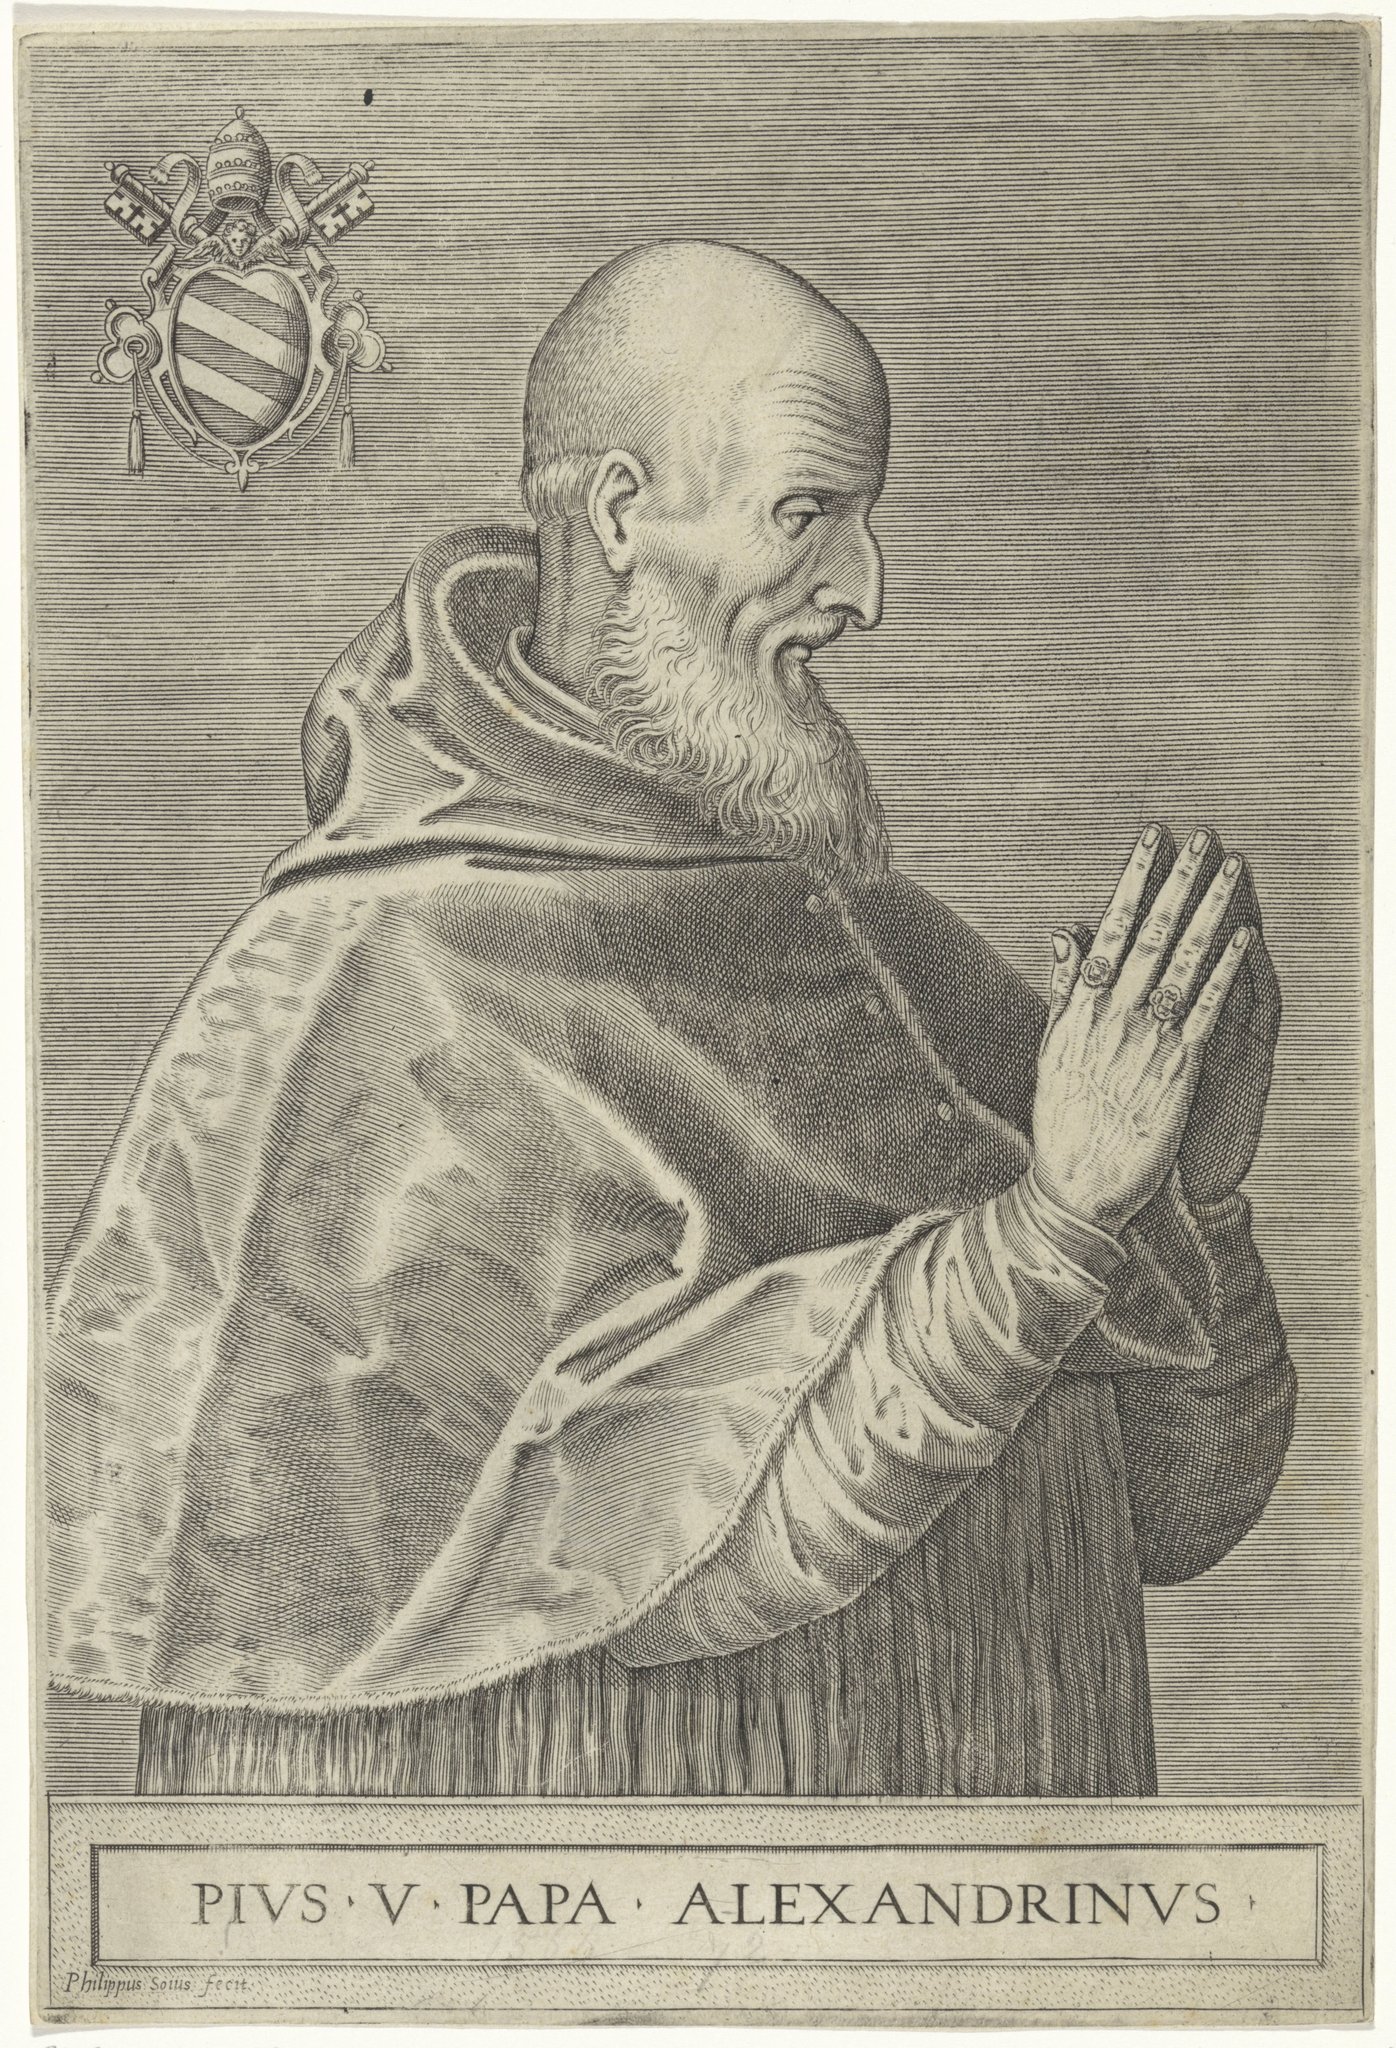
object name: print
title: Portretten van pausen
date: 1568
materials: paper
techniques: engraving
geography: rome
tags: pius v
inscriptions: collector's mark: Lugt 2228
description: Portret van paus Pius V met gevouwen handen. Linksboven zijn pauselijk wapenschild.